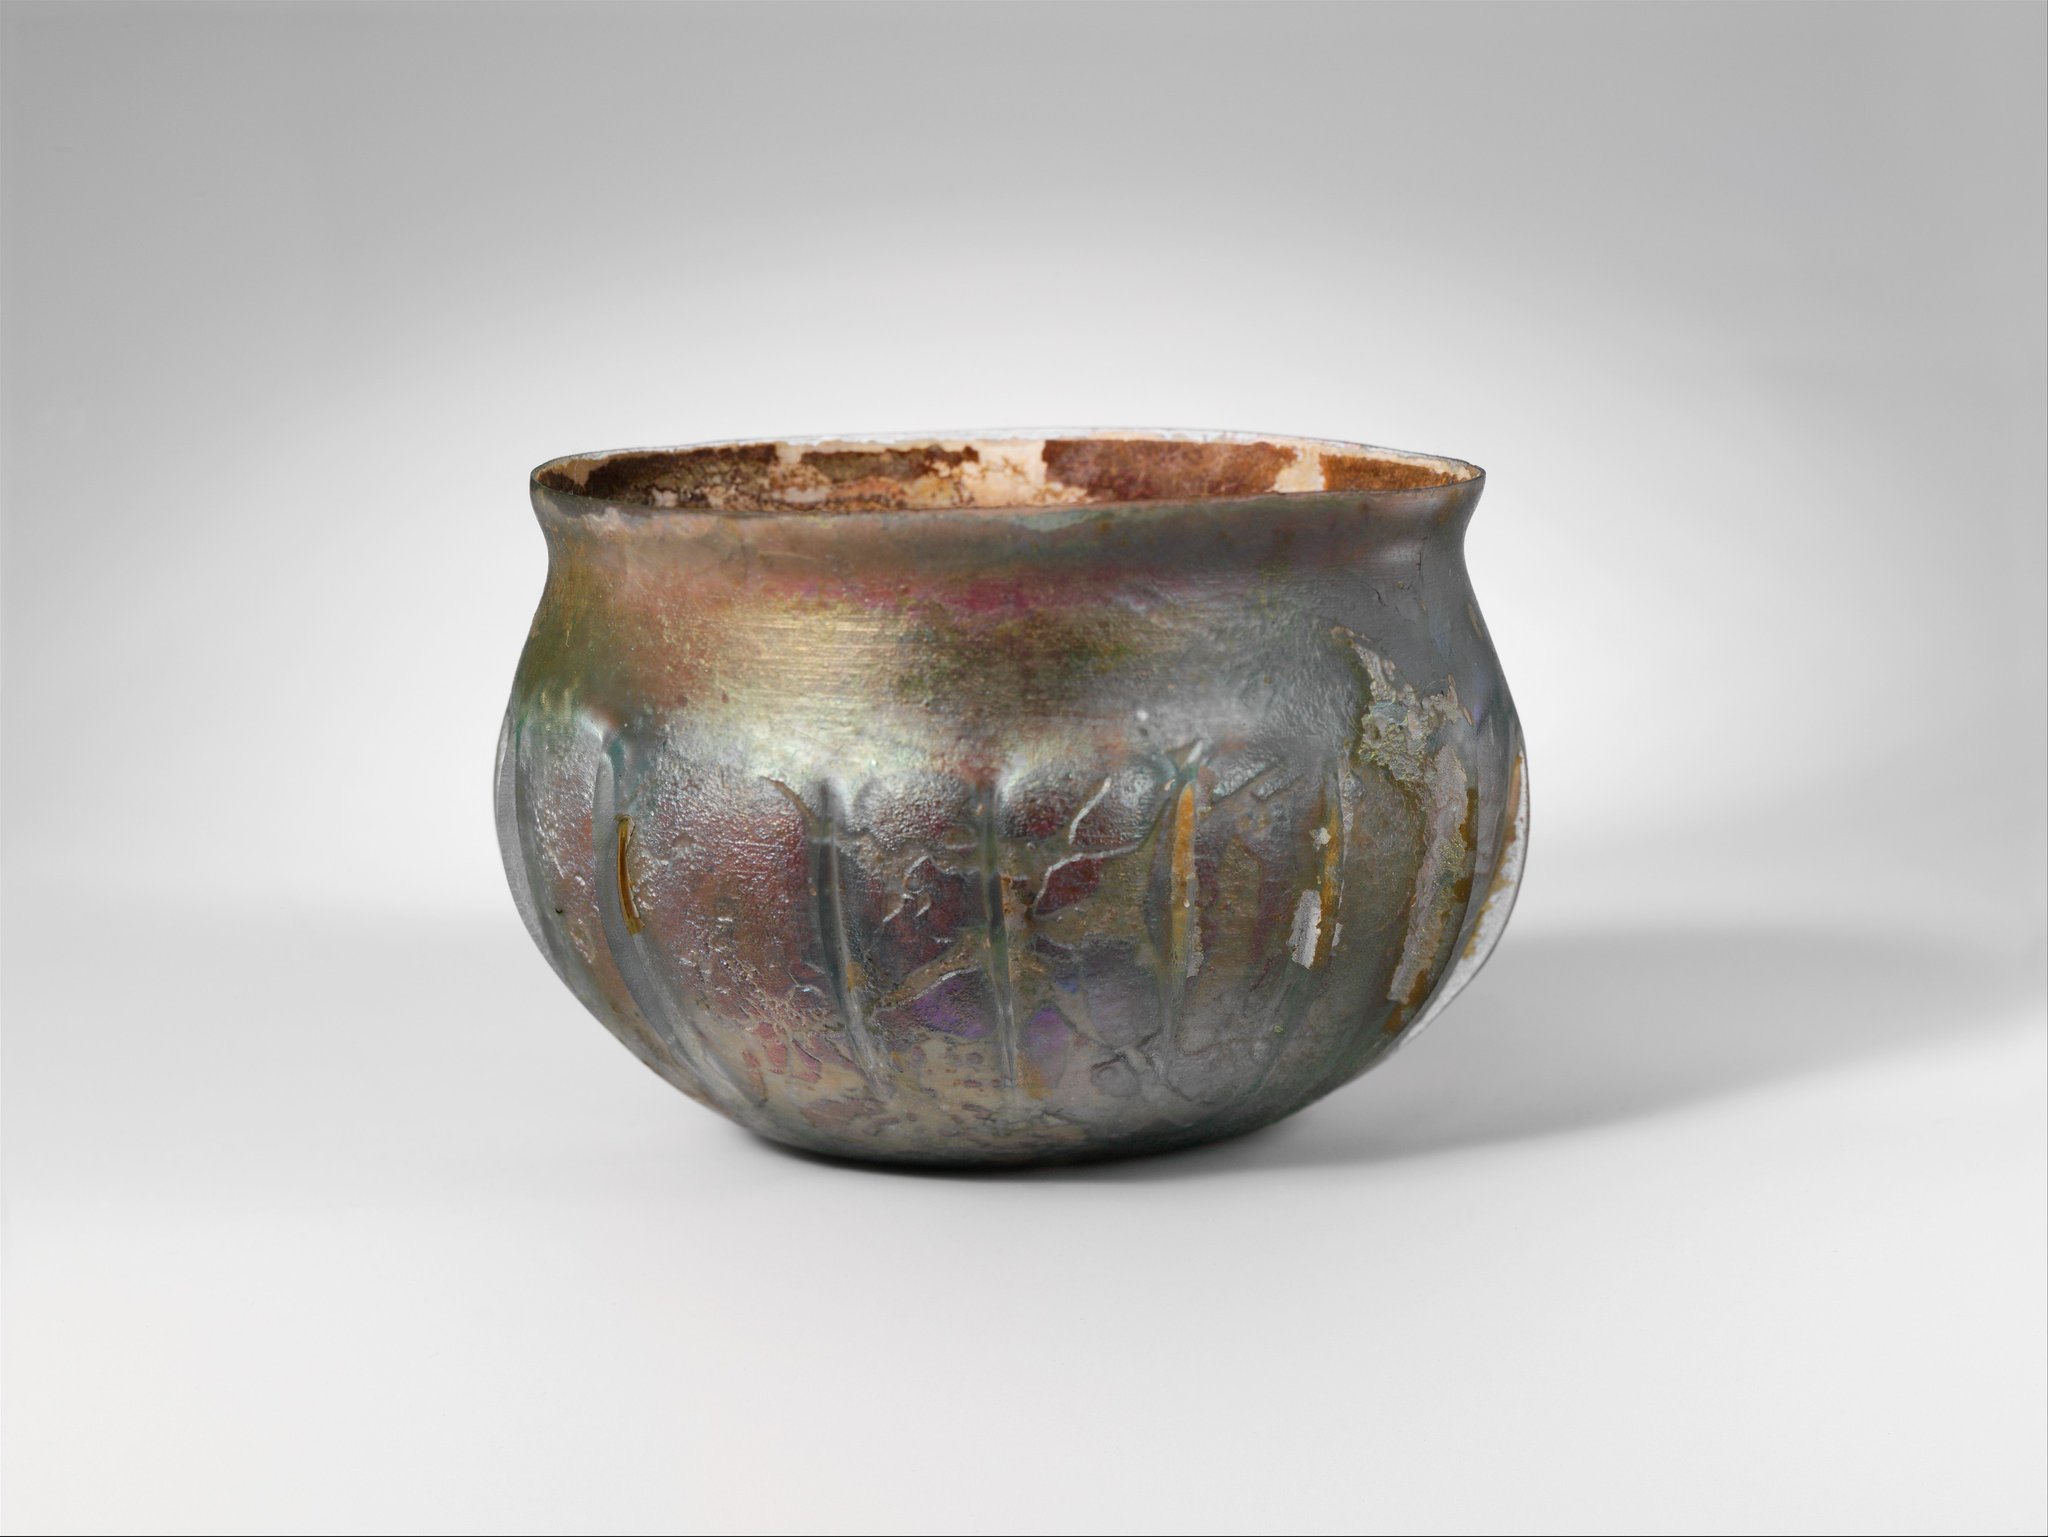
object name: bowl, rippenschale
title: Glass ribbed bowl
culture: roman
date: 34-66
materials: glass